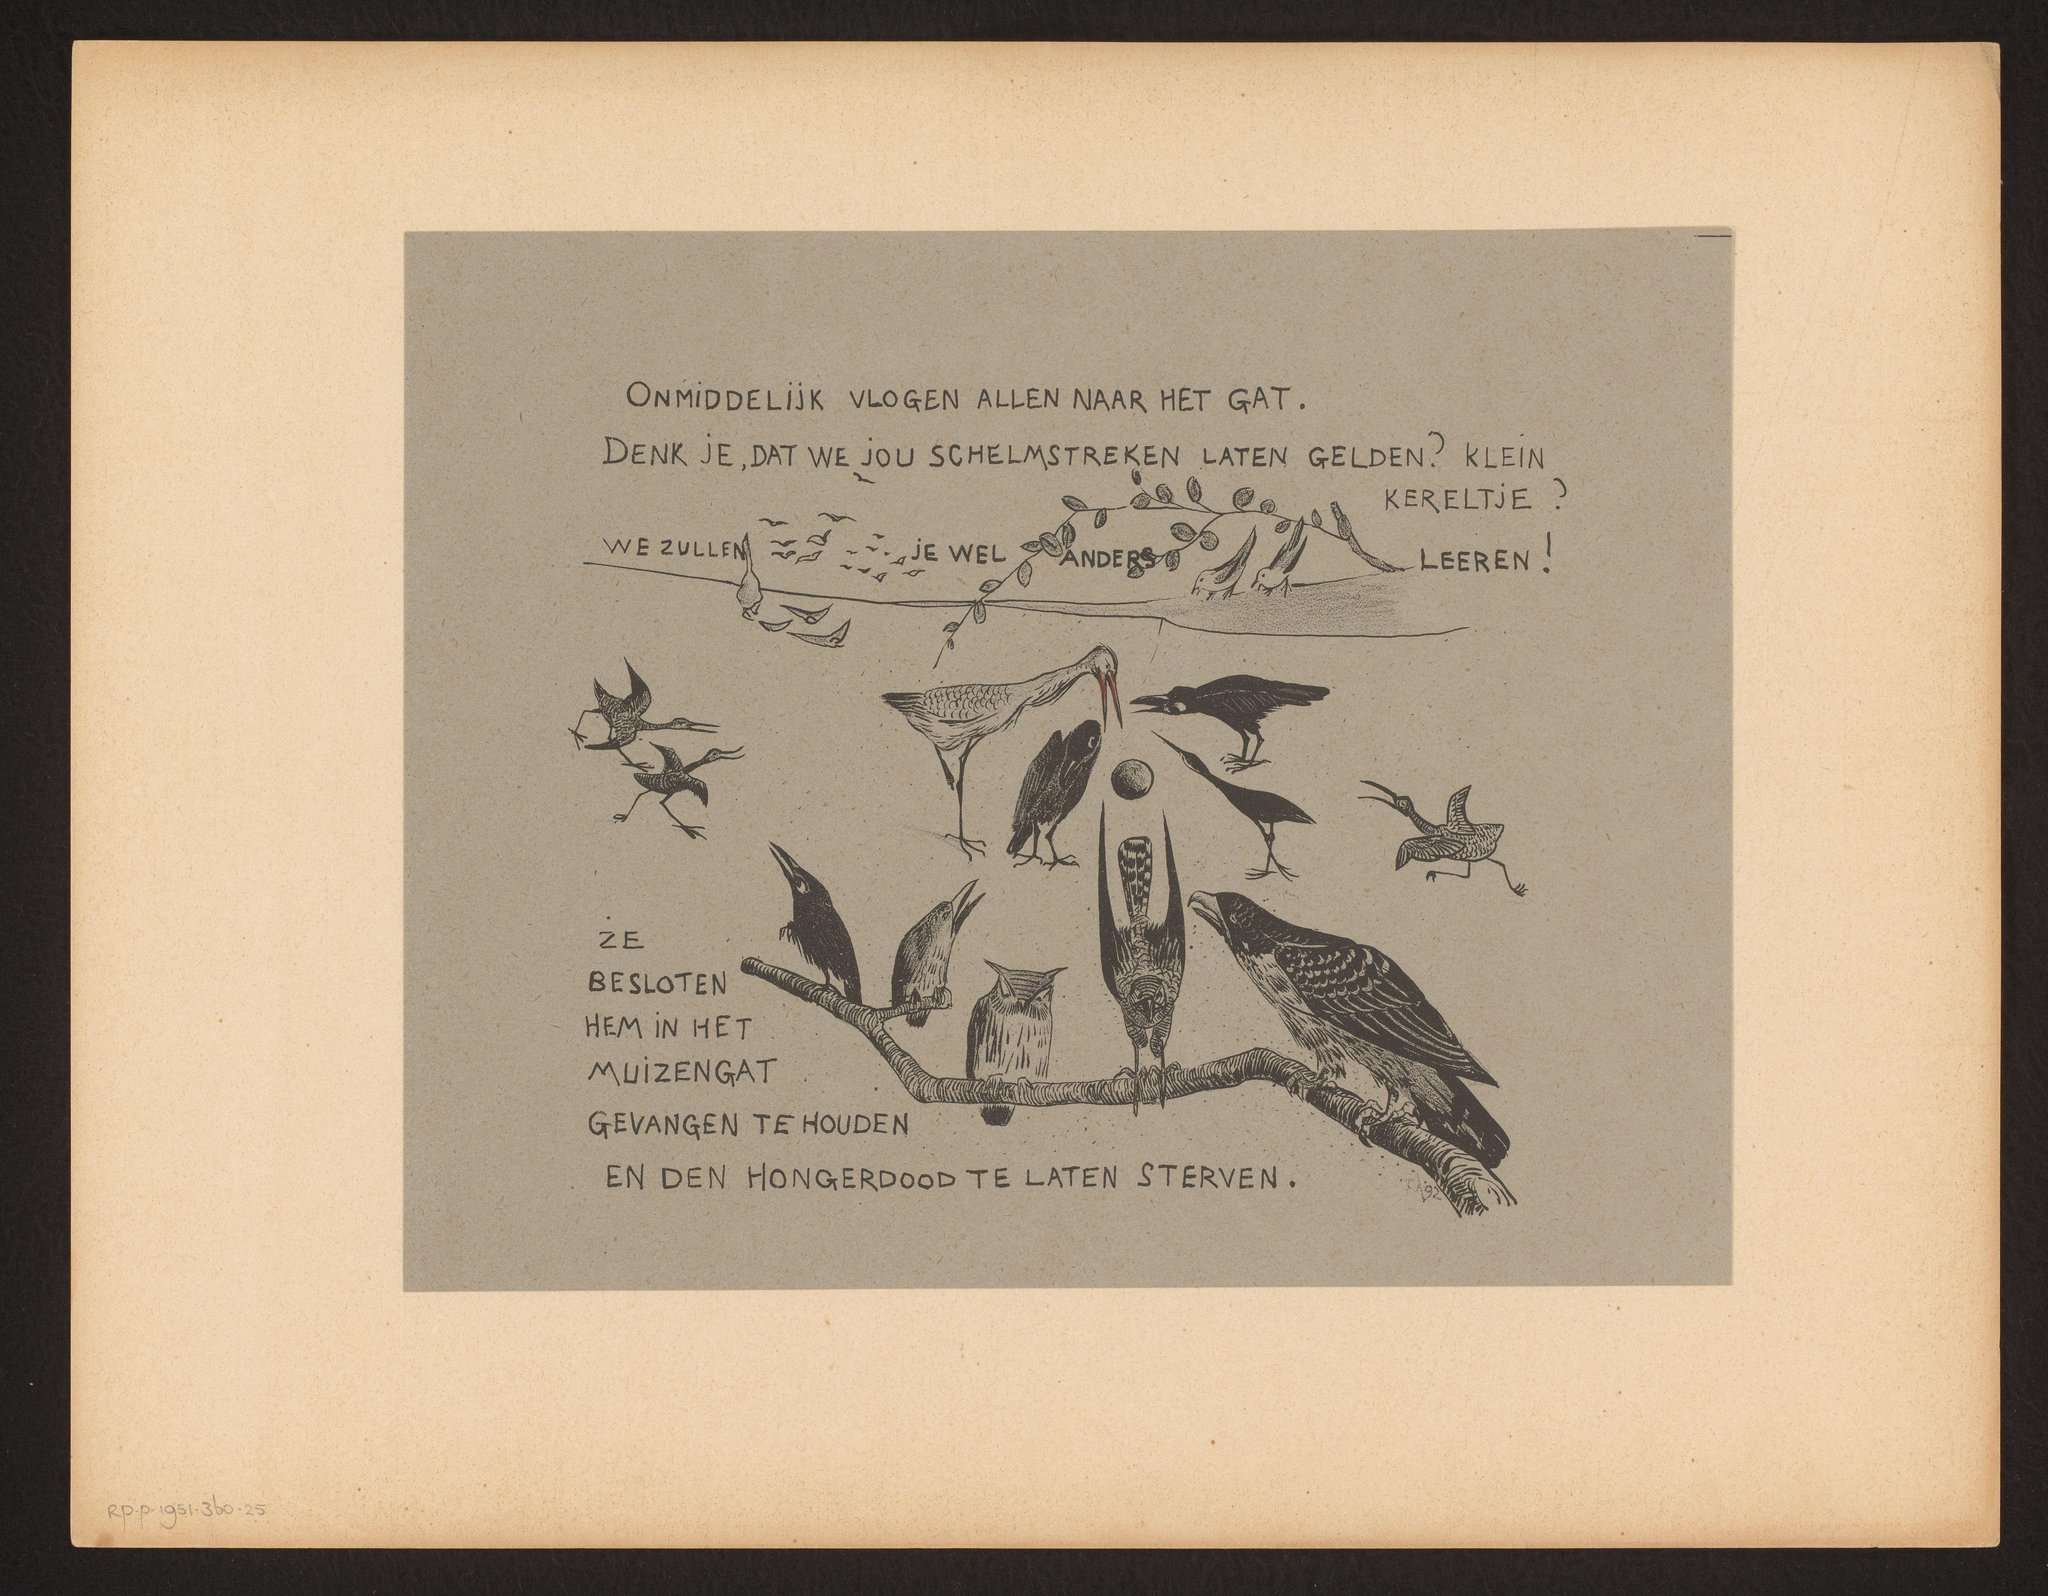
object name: print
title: Tekstblad met diverse vogelsoorten bij het muizenhol waarin de winterkoning verdween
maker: theo van hoytema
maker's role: draughtsman, painter, print maker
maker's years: 1863-1917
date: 1892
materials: paper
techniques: lithograph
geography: the hague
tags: song-birds: wren, groups of birds, pit, hole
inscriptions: date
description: Zowel tekst als afbeelding zijn gelithografeerd.